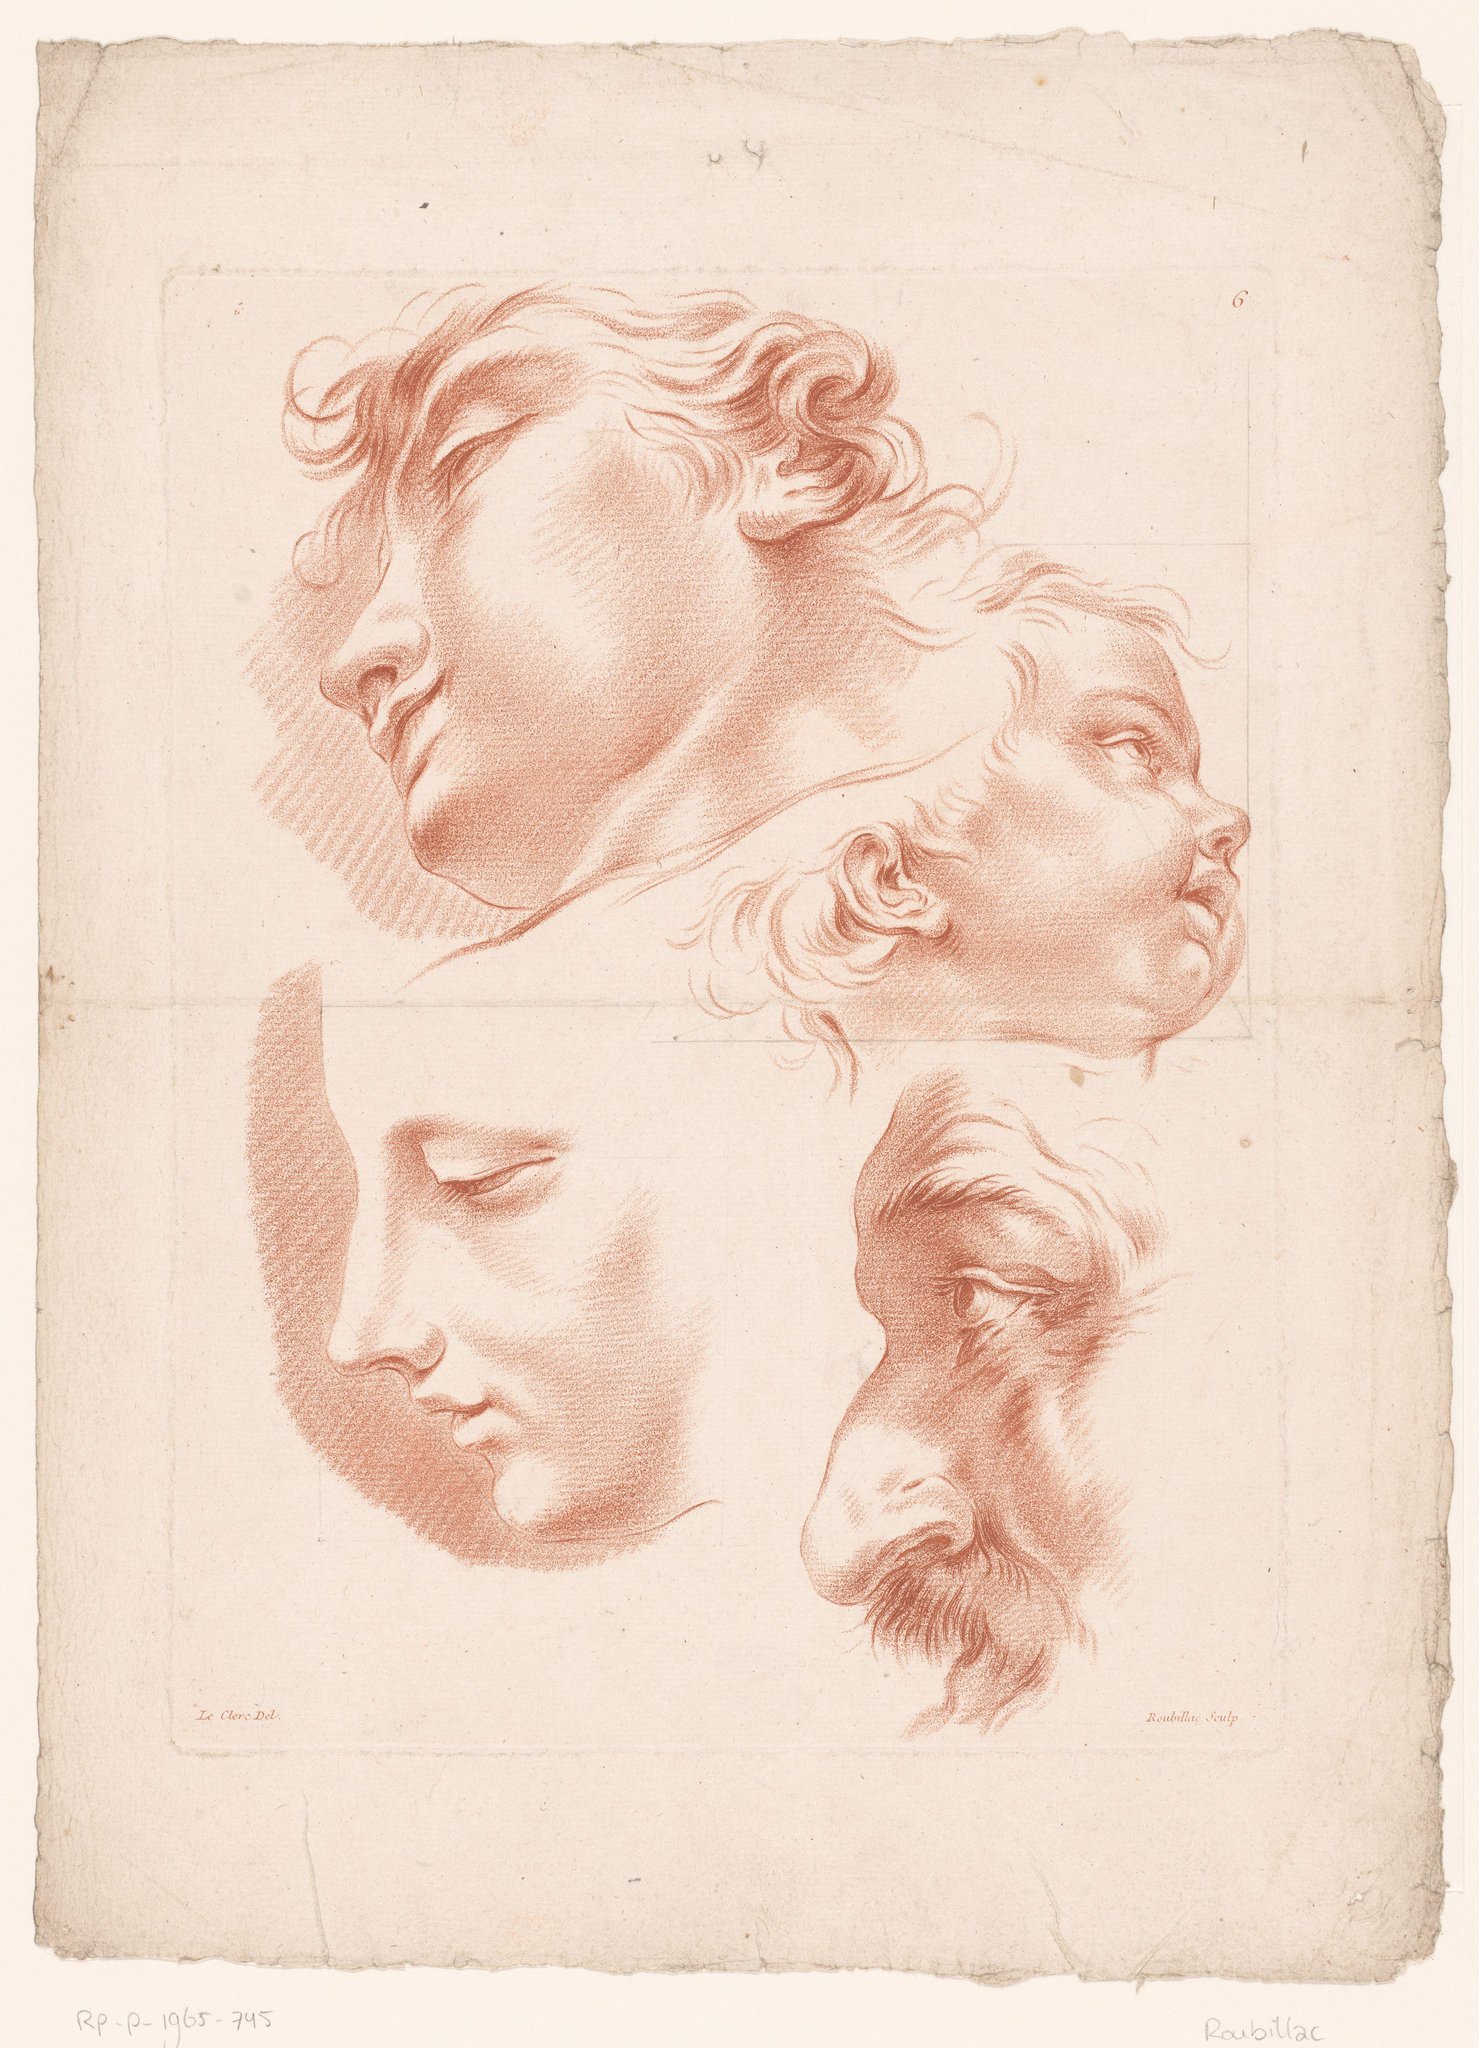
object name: print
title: Koppen van twee mannen, een vrouw en een kind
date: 1749-1849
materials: paper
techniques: printmaking, etching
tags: drawing, sketch, head (human)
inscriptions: collector's mark: Lugt 2228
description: Onbekend tot welk deel van 'Principes du Dessin d'après Nature' deze prent behoort.